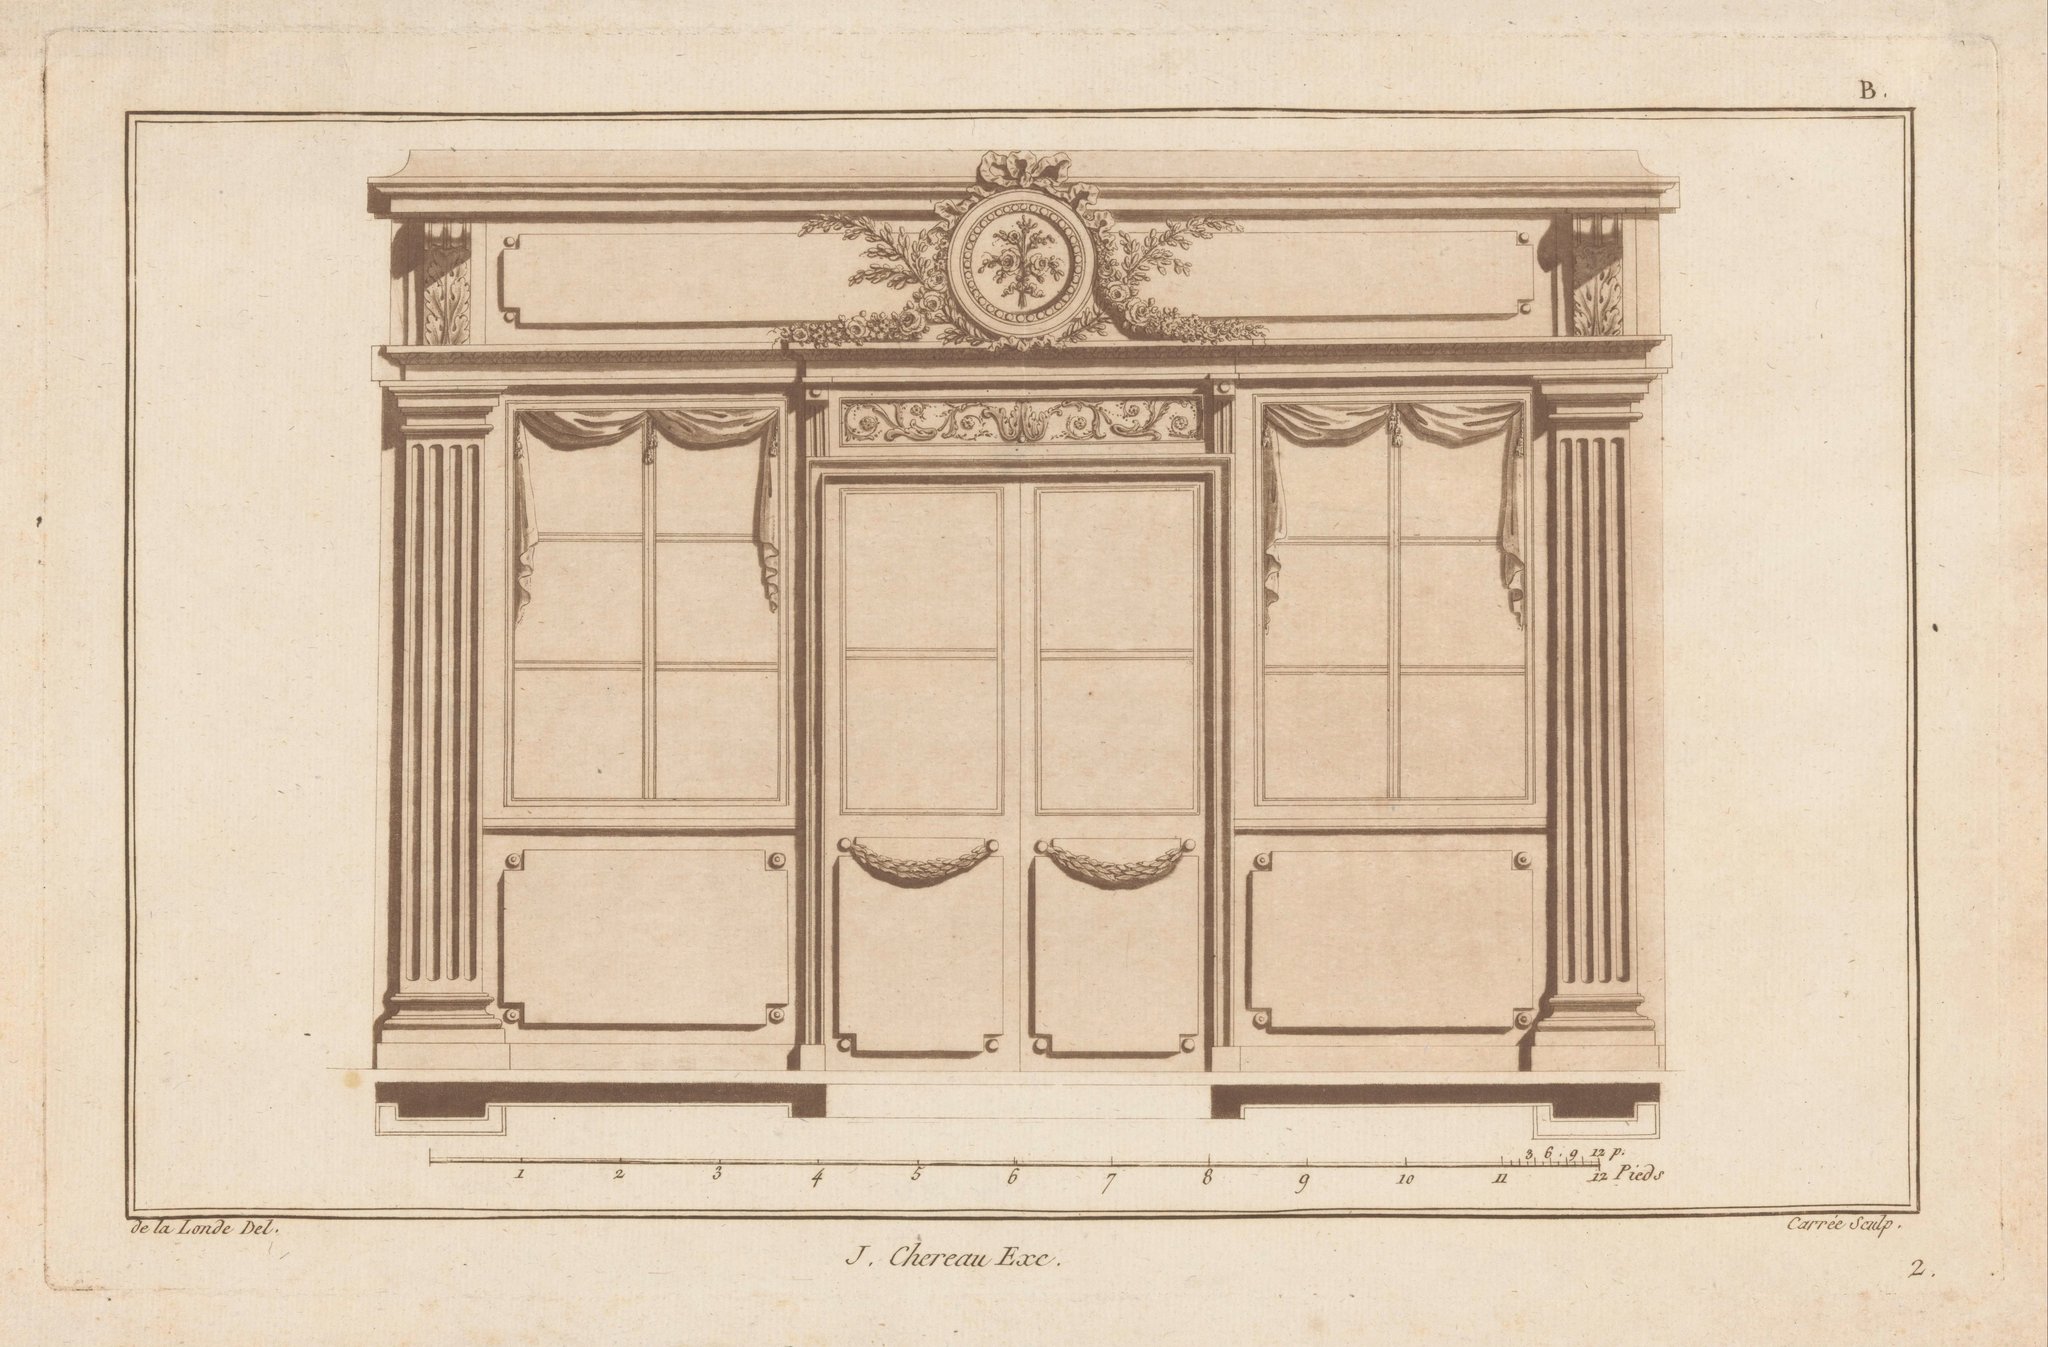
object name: print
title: Ier Cahier de Menuiserie pour Façade et Elévation de Boutique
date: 1788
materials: paper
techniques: aquatint, etching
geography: paris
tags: half-column, pilaster ~ architecture, façade (of house or building)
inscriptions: collector's mark: Lugt 2760, collector's mark: Lugt 2228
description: Een façade met in het midden twee deuren met guirlandes. Aan weerszijden ramen met gordijnen en pilasters. Aan de bovenzijde consoles en in het midden een medaillon met bloemen en ranken.